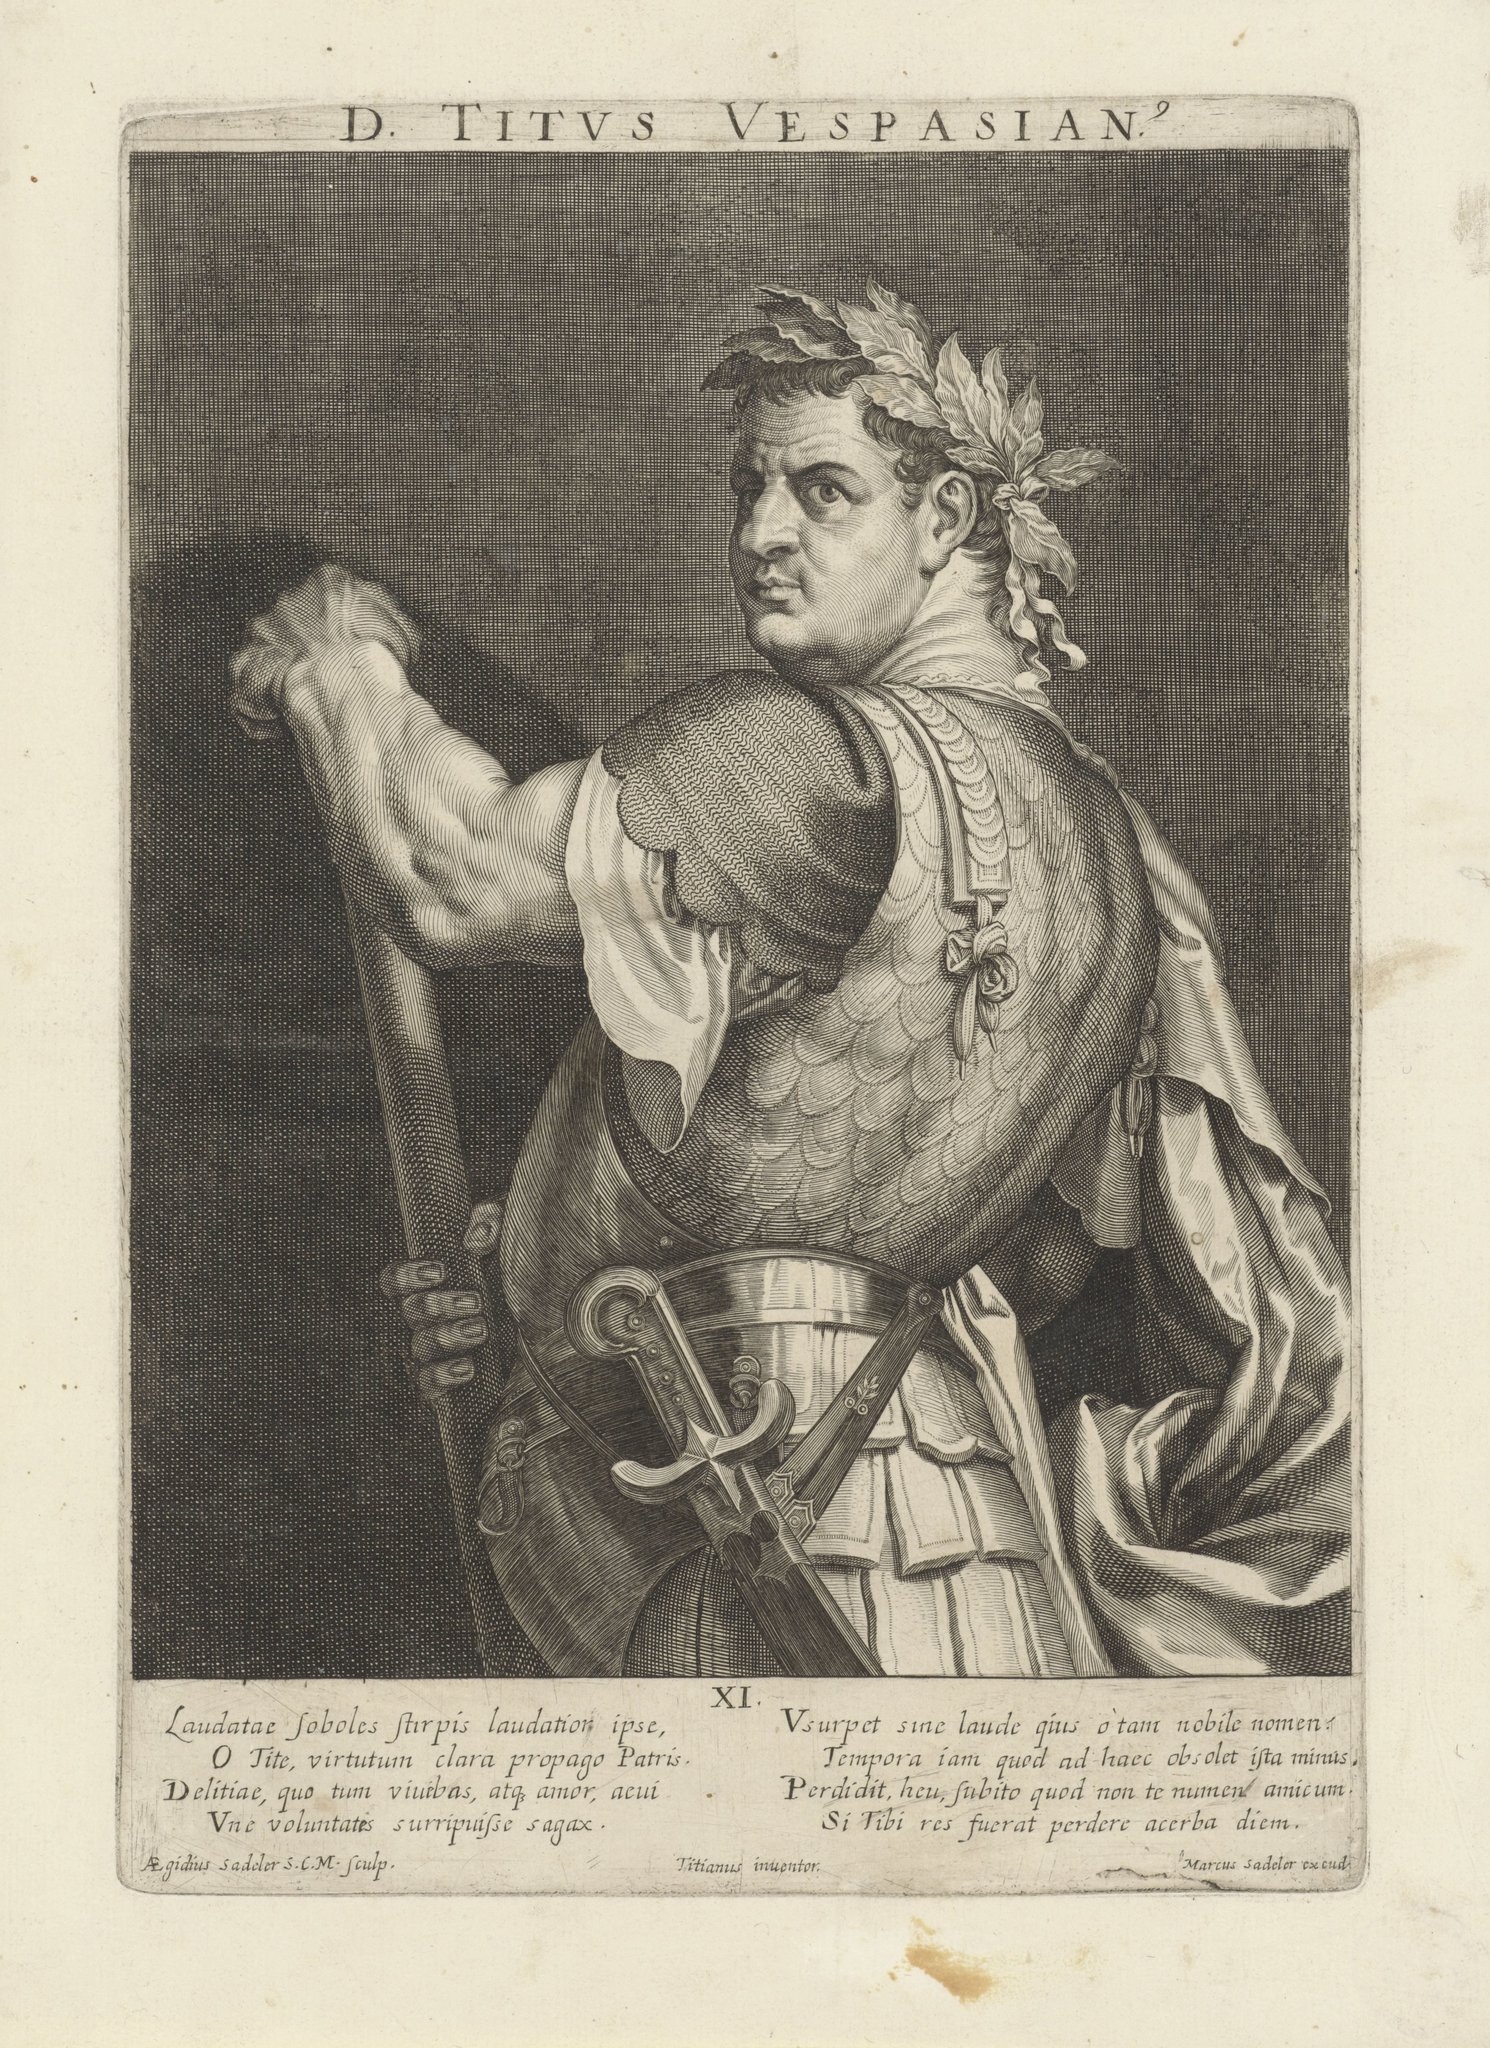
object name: print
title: Portret van keizer Titus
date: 1597-1629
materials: paper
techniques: engraving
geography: prague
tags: rome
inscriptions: collector's mark: Lugt 240